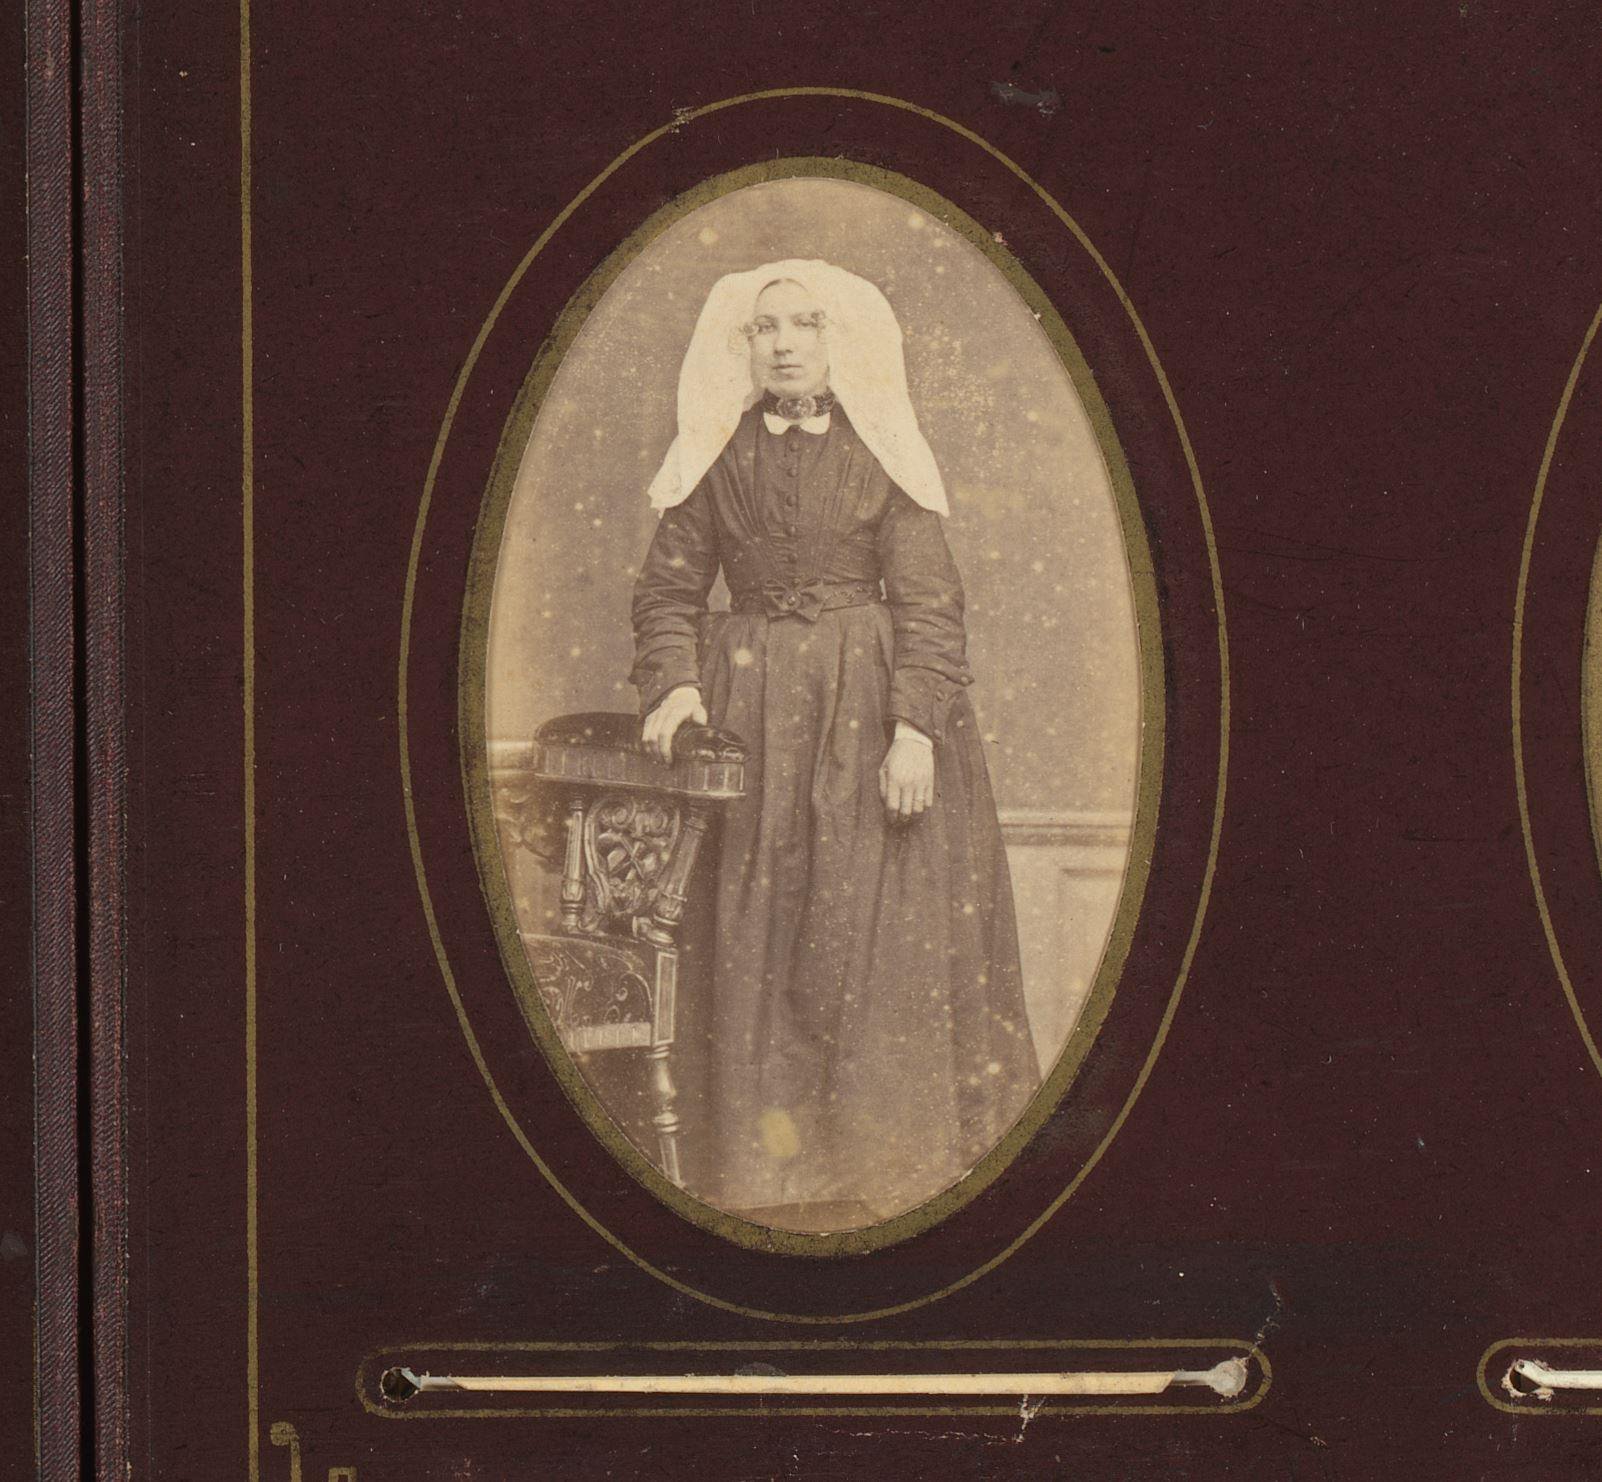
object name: carte de visite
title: Portret van een vrouw met witte klederdrachtmuts, staand bij een stoel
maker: gerrit hoogwinkel jr.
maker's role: fotograaf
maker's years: 1837-1890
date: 1873-1887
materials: cardboard, photographic support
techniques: albumen print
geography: rotterdam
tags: historical persons - bb - woman, head-gear: cap, folk costume, regional costume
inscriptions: inscription: ‘Photographie/ G. Hoogwinkel/ Rotterdam, 281. Hoogstraat./ Van deze Photographie kunnen steeds besteld worden/ in alle Formaten zelfs levensgroot onder No. 22393’